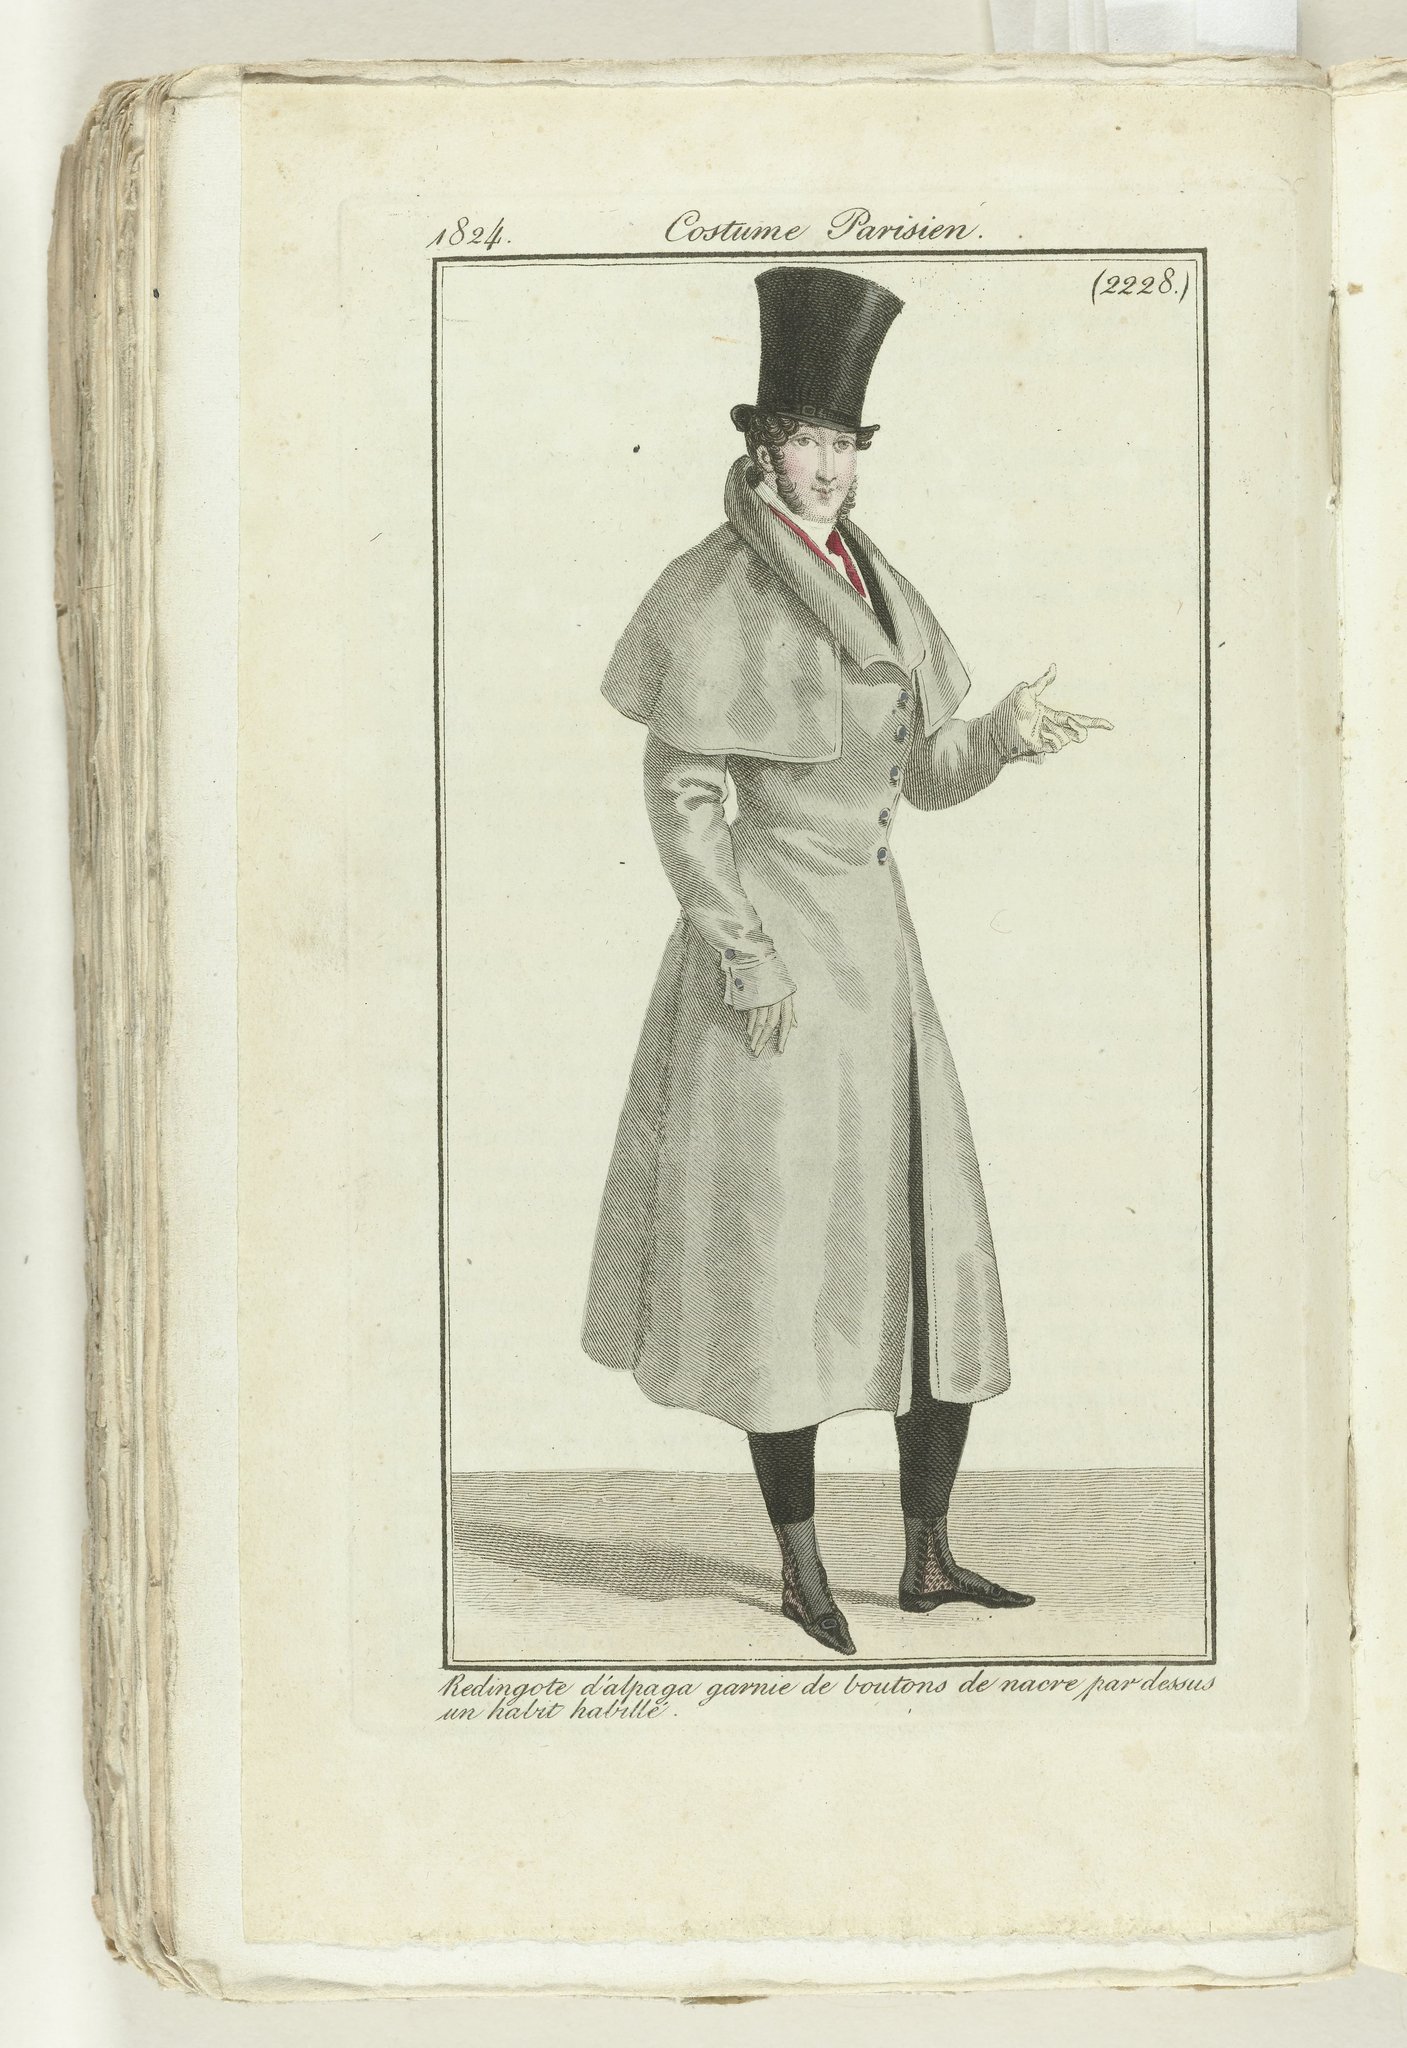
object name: fashion print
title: Journal des Dames et des Modes 1824, Costume Parisien (2228)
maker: Anonymous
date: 1824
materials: paper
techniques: etching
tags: fashion plates, clothes, costume (+ men's clothes)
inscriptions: date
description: Prent uit het tijdschrift Journal des Dames et des Modes, 1824.